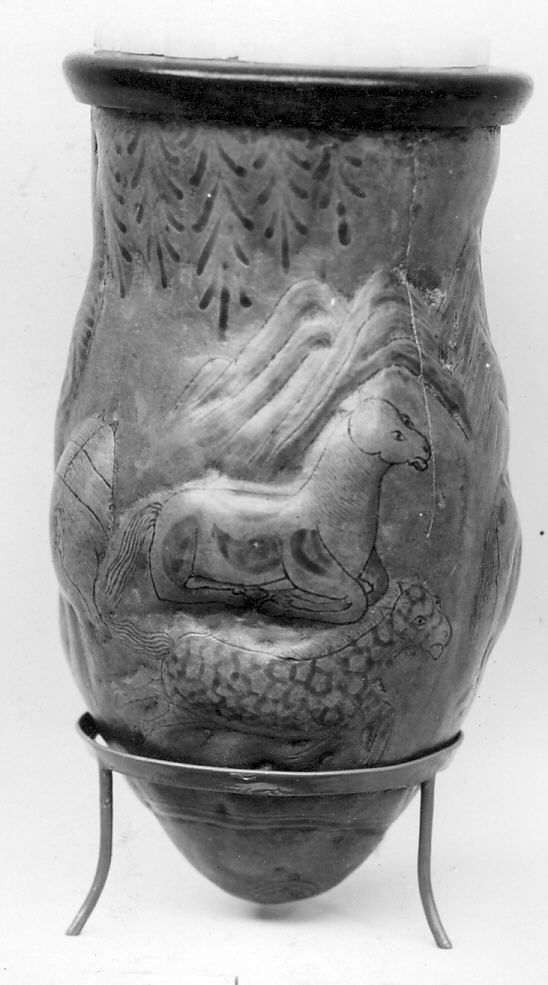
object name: cricket cage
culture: chinese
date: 1701-1900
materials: jade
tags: horses